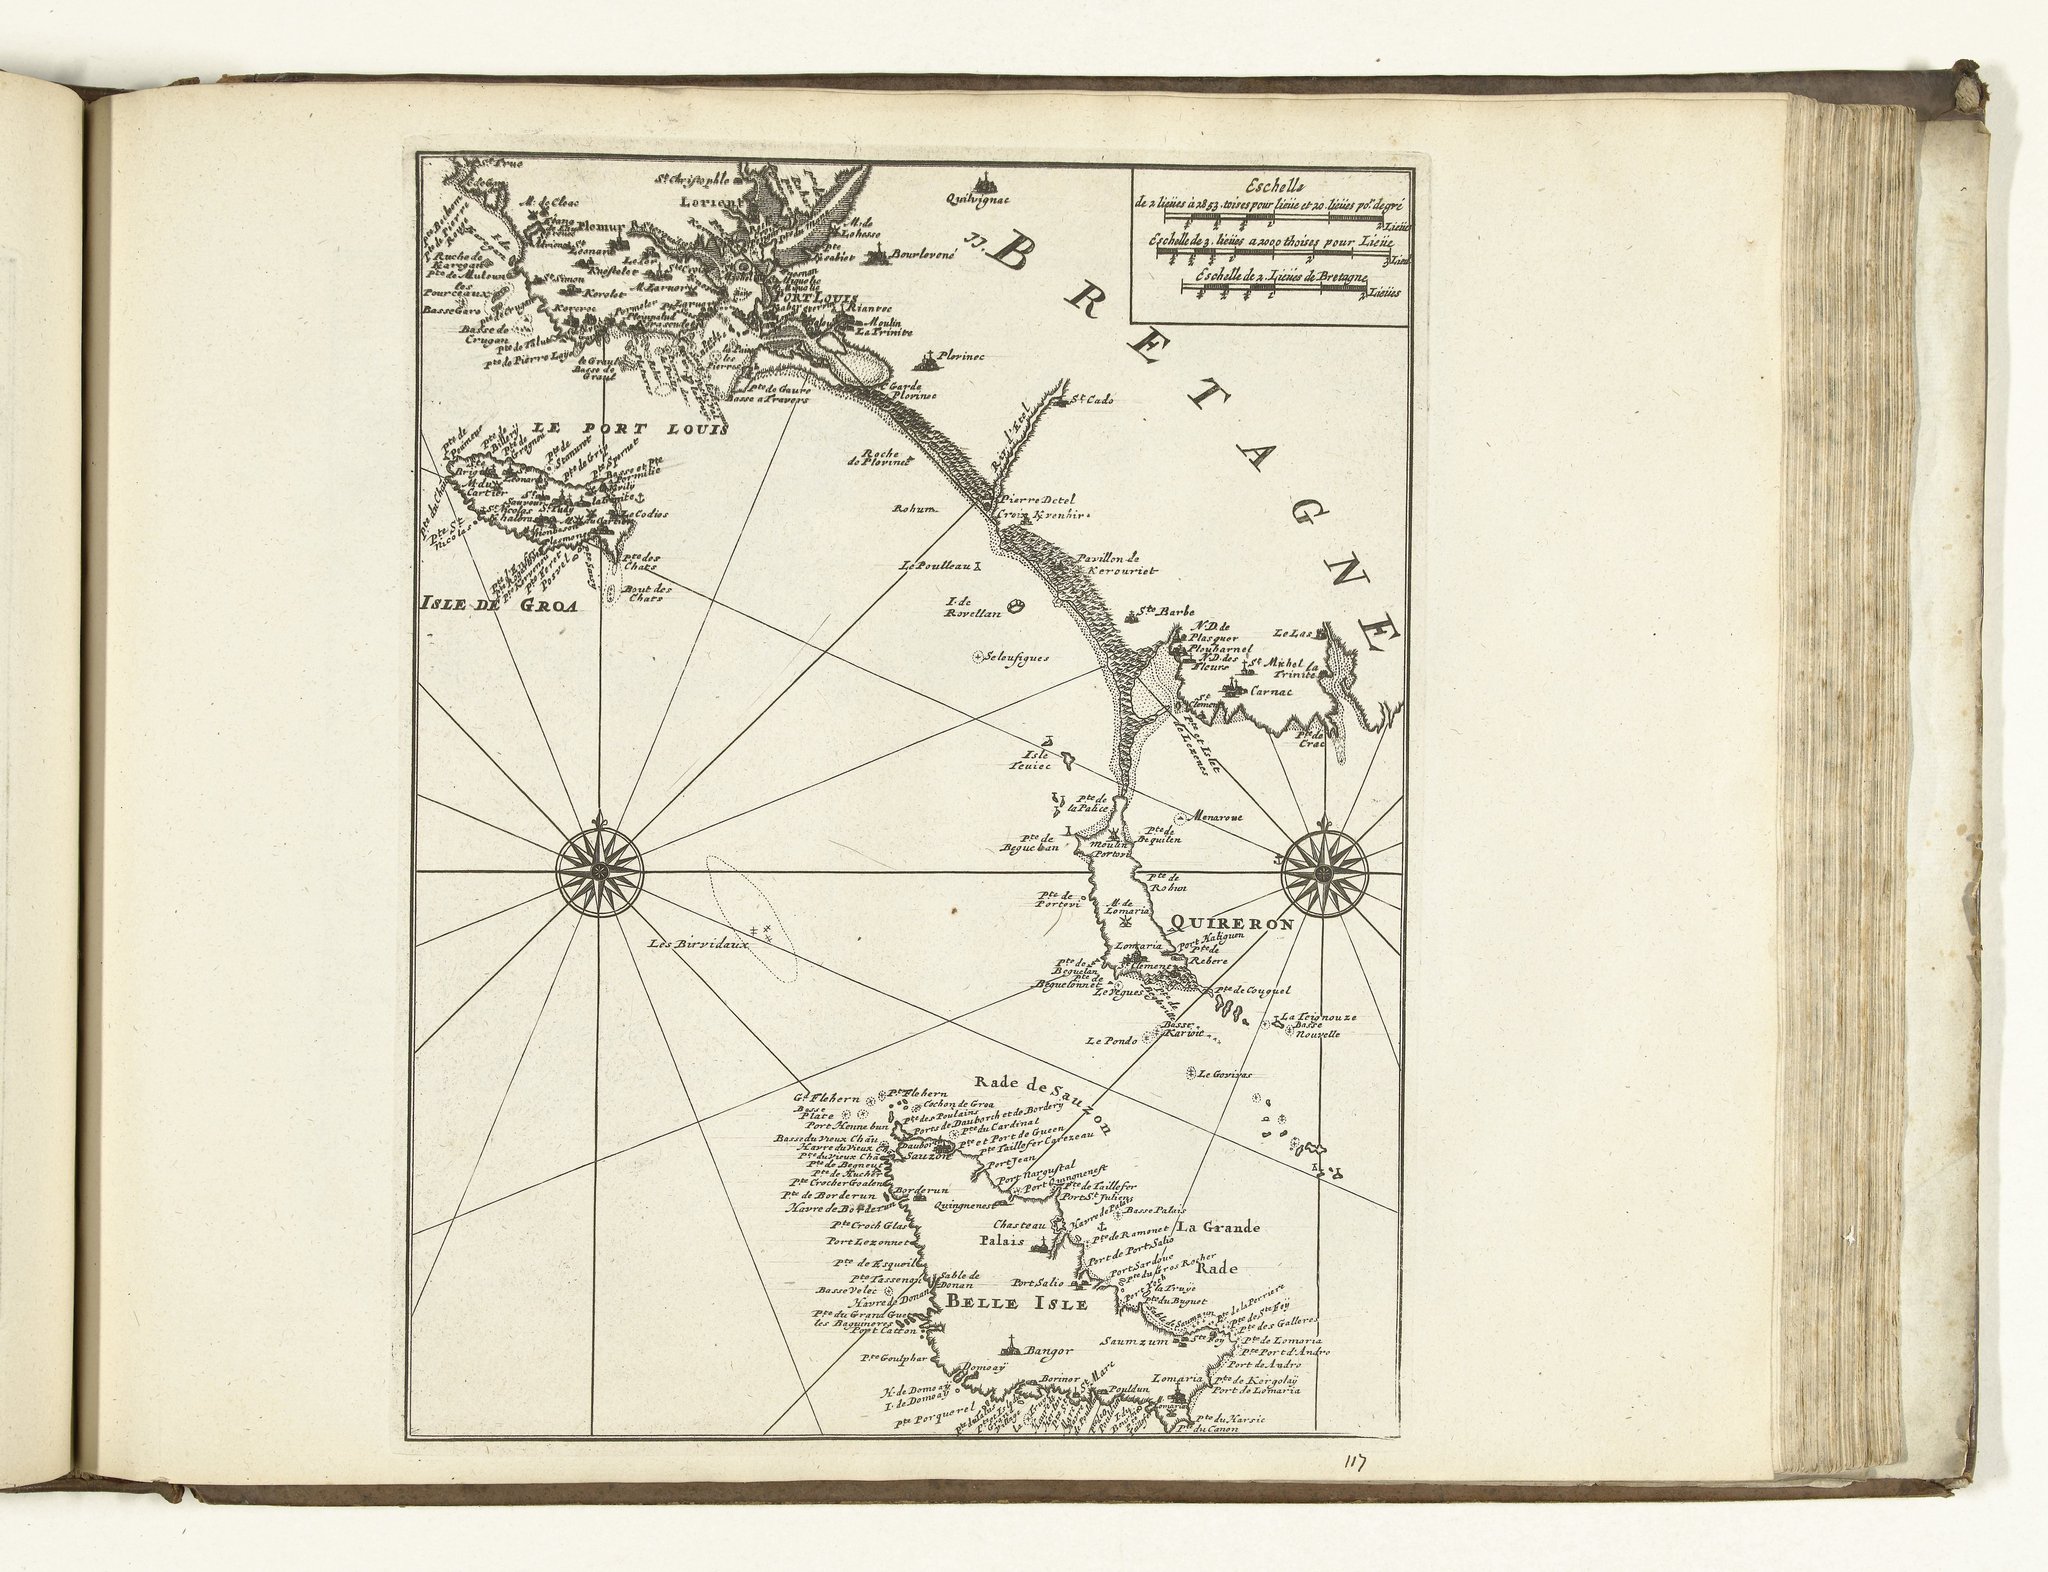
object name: print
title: Les Forces de l'Europe, Asie, Afrique et Amerique (...) Comme aussi les Cartes des Côtes de France et d'Espagne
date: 1726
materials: paper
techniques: etching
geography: northern netherlands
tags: maps of separate countries or regions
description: Kaart van de zuidkust van Bretagne tussen Port-Louis en Belle Ile. Plaat nr. 117 in deel V van het prentwerk: Les Forces de l'Europe, Asie, Afrique et Amerique ... Comme aussi les Cartes des Côtes de France et d'Espagne uit 1726, dit eerste deel met 238 met de hand genummerde platen van vermaarde sterke steden en vestingen in het kader van de Spaanse Successieoorlog 1701-1713. Voor het merendeel zijn deze platen gekopieerd naar de anonieme Franse platen van vermaarde sterke steden en vestingen: in Les forces de l'Europe en in: Le theatre de la guerre, dans les Pays-Bas, beide oorspronkelijk uitgegeven door Nicolas de Fer te Parijs (1693-1697) in het kader van de Negenjarige Oorlog. Opschriften in het Frans.